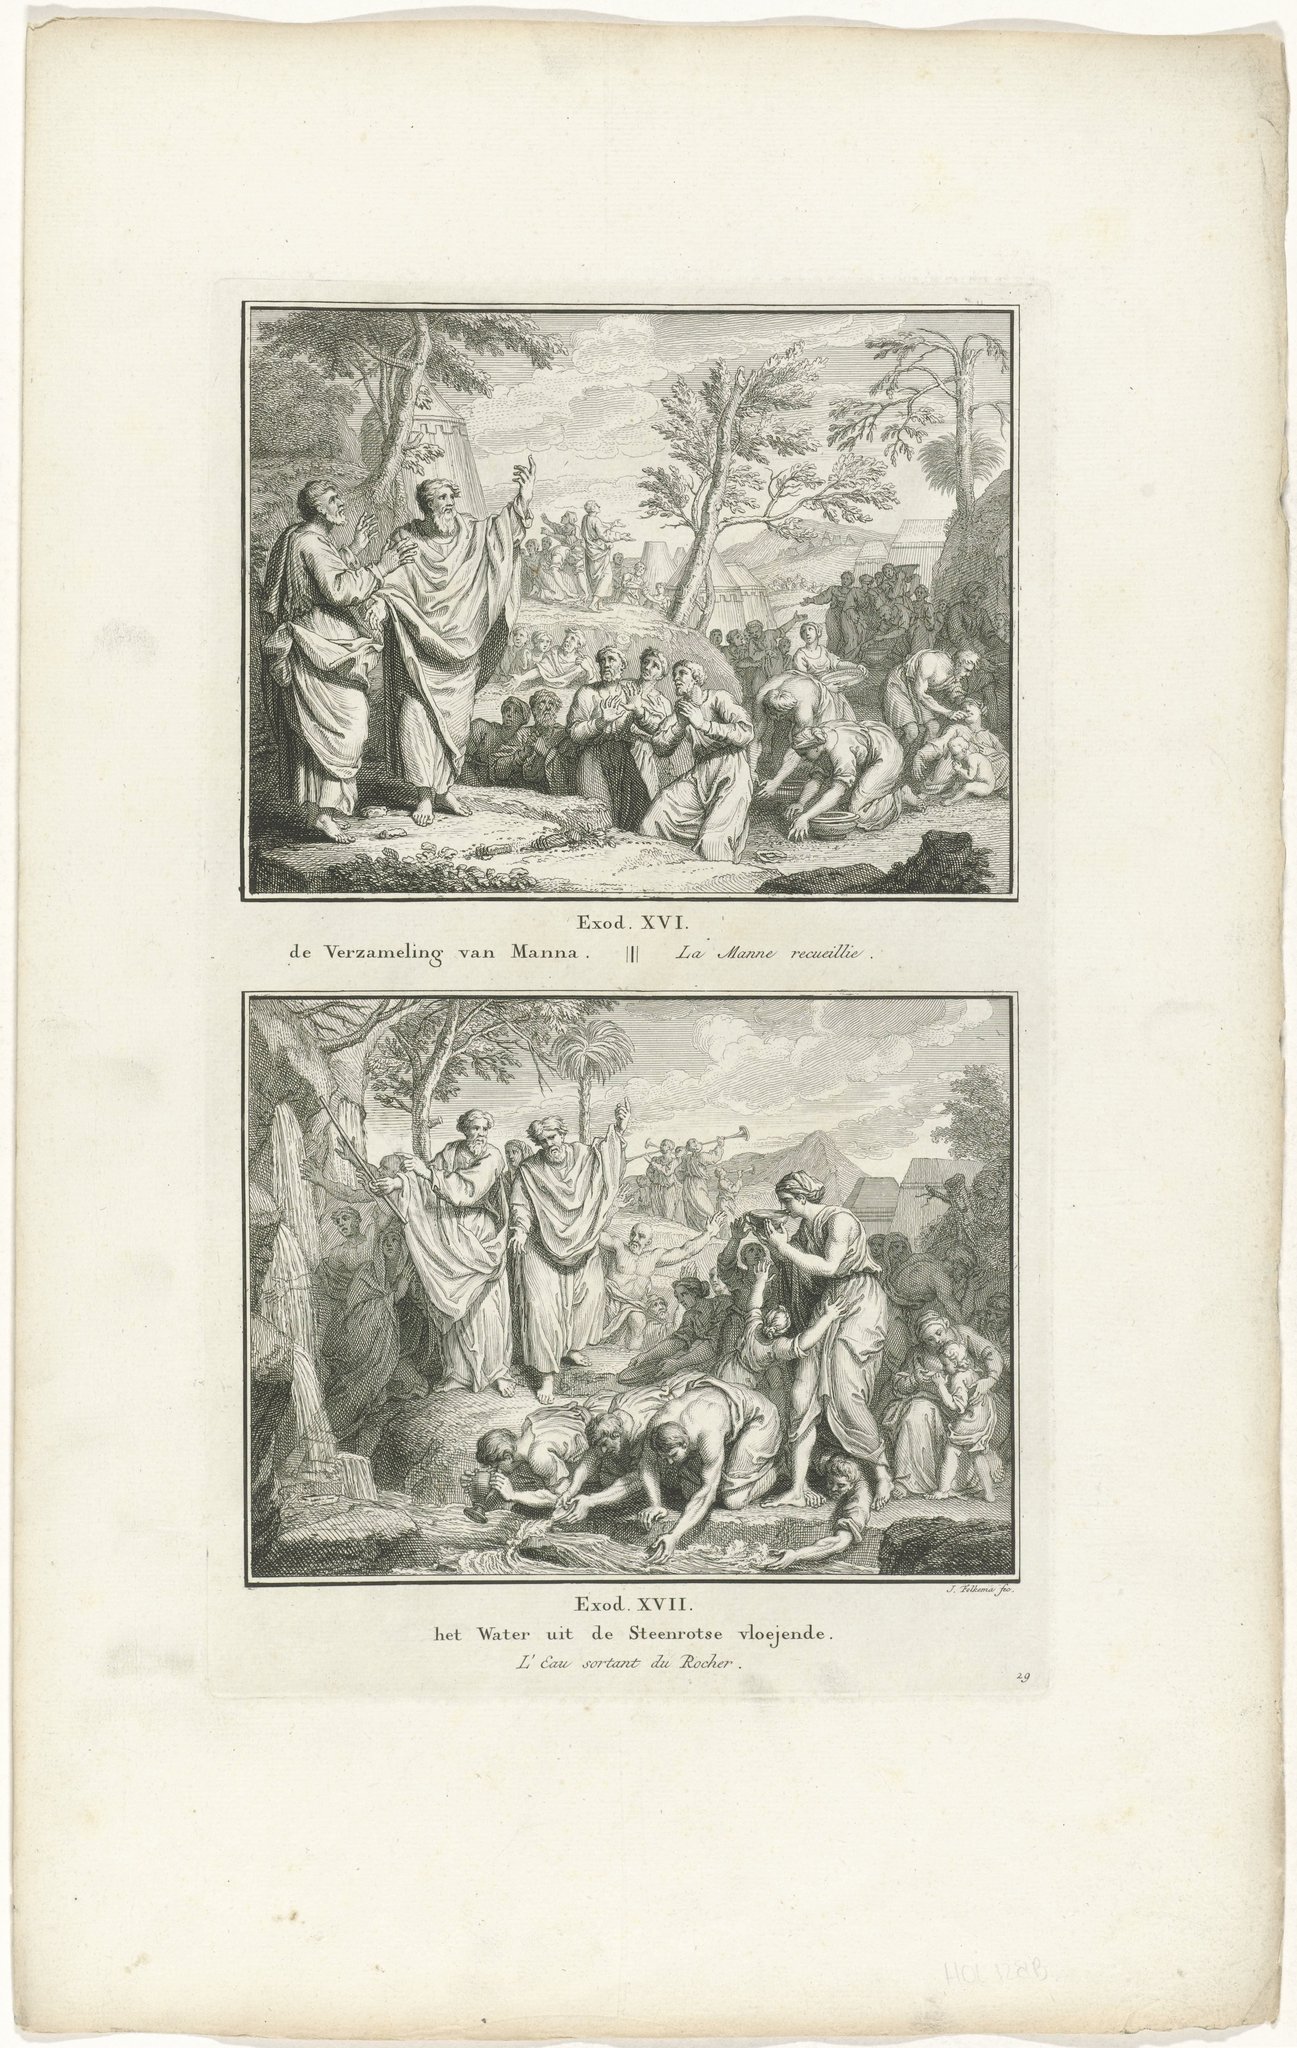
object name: book illustration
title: Israëlieten rapen het manna en Mozes slaat water uit een rots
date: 1791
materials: paper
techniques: etching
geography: amsterdam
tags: the gathering of manna (in baskets and pots), moses striking water from the rock (exodus 17:1-7; numbers 20:2-13)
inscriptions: collector's mark, collector's mark: Lugt 2233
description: Twee Bijbelse voorstellingen uit Ex. 16 en 17. De Israëlieten rapen het manna van de grond dat uit een wolk regent, en Mozes slaat met zijn staf water uit een rots zodat de Israëlieten kunnen drinken. Twee voorstellingen van één plaat, elk voorzien van een titel in het Nederlands en Frans. Geheel rechtsonder genummerd: 29.